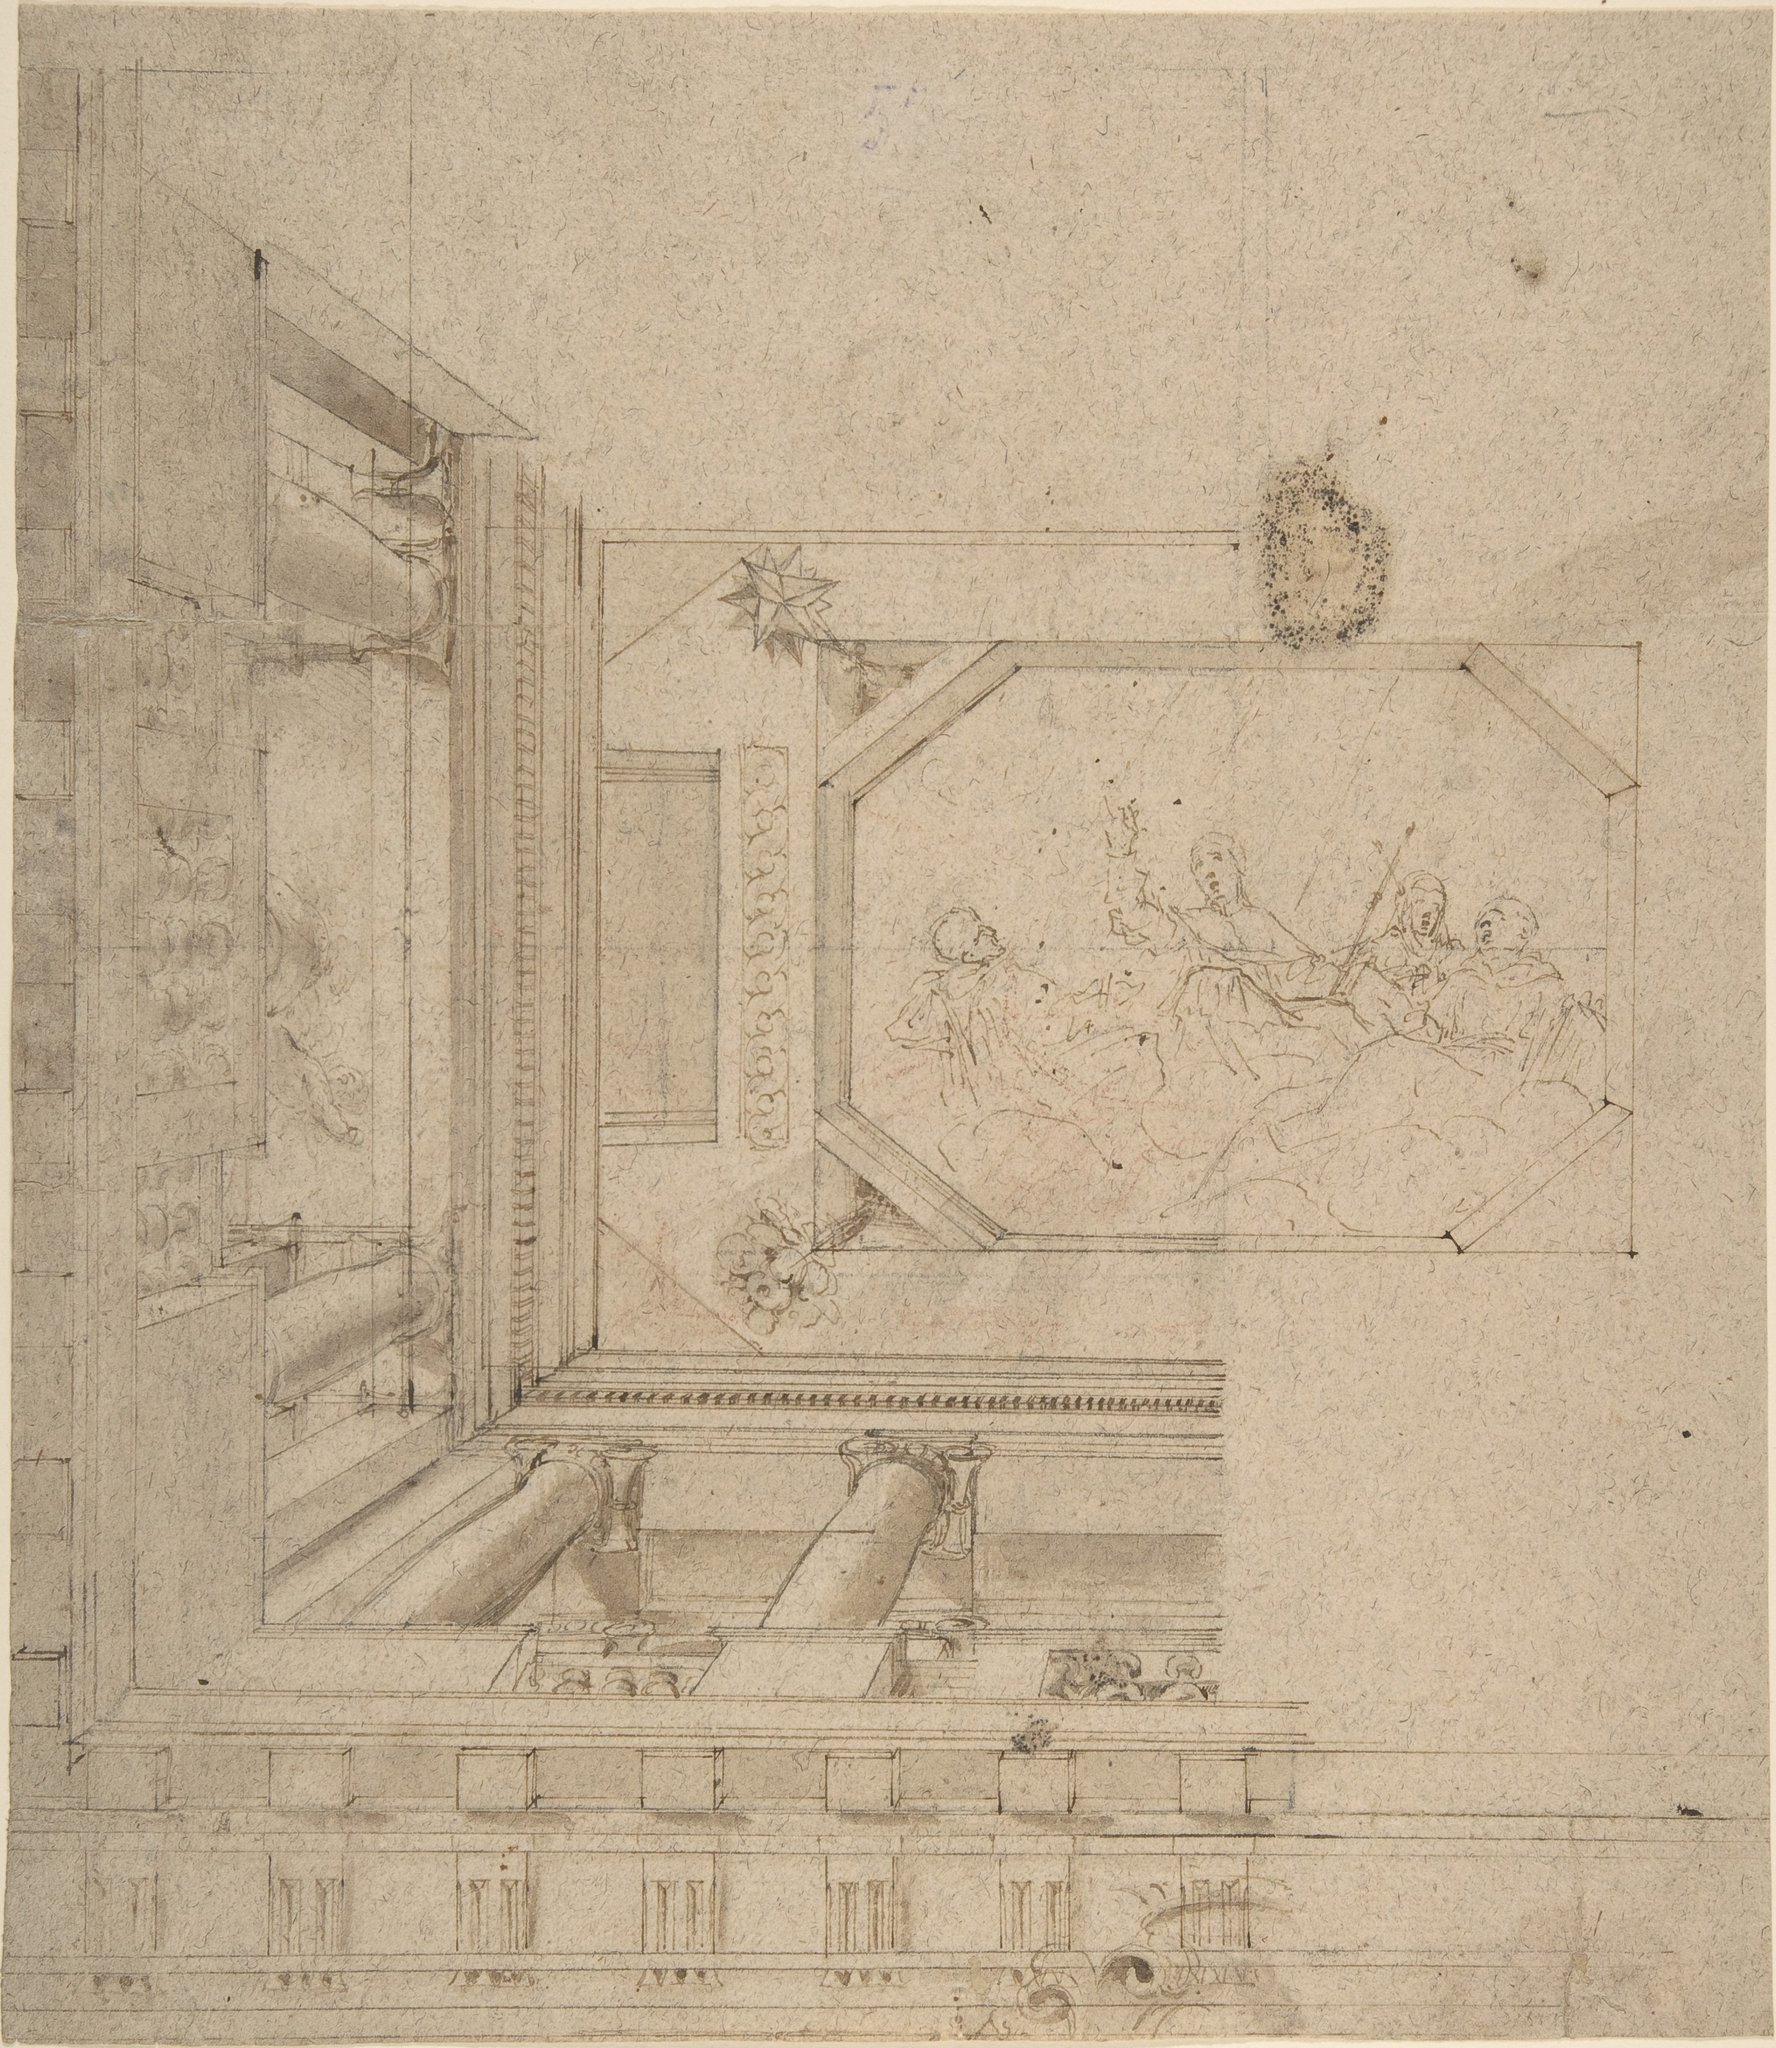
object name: drawing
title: Architectural Elevation, Part of a Ceiling and Balustrade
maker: anonymous, italian, 17th or 18th century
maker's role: artist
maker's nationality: italian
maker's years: 1600-1799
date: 1600-1800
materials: ink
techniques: pen, wash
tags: architecture,ceilings